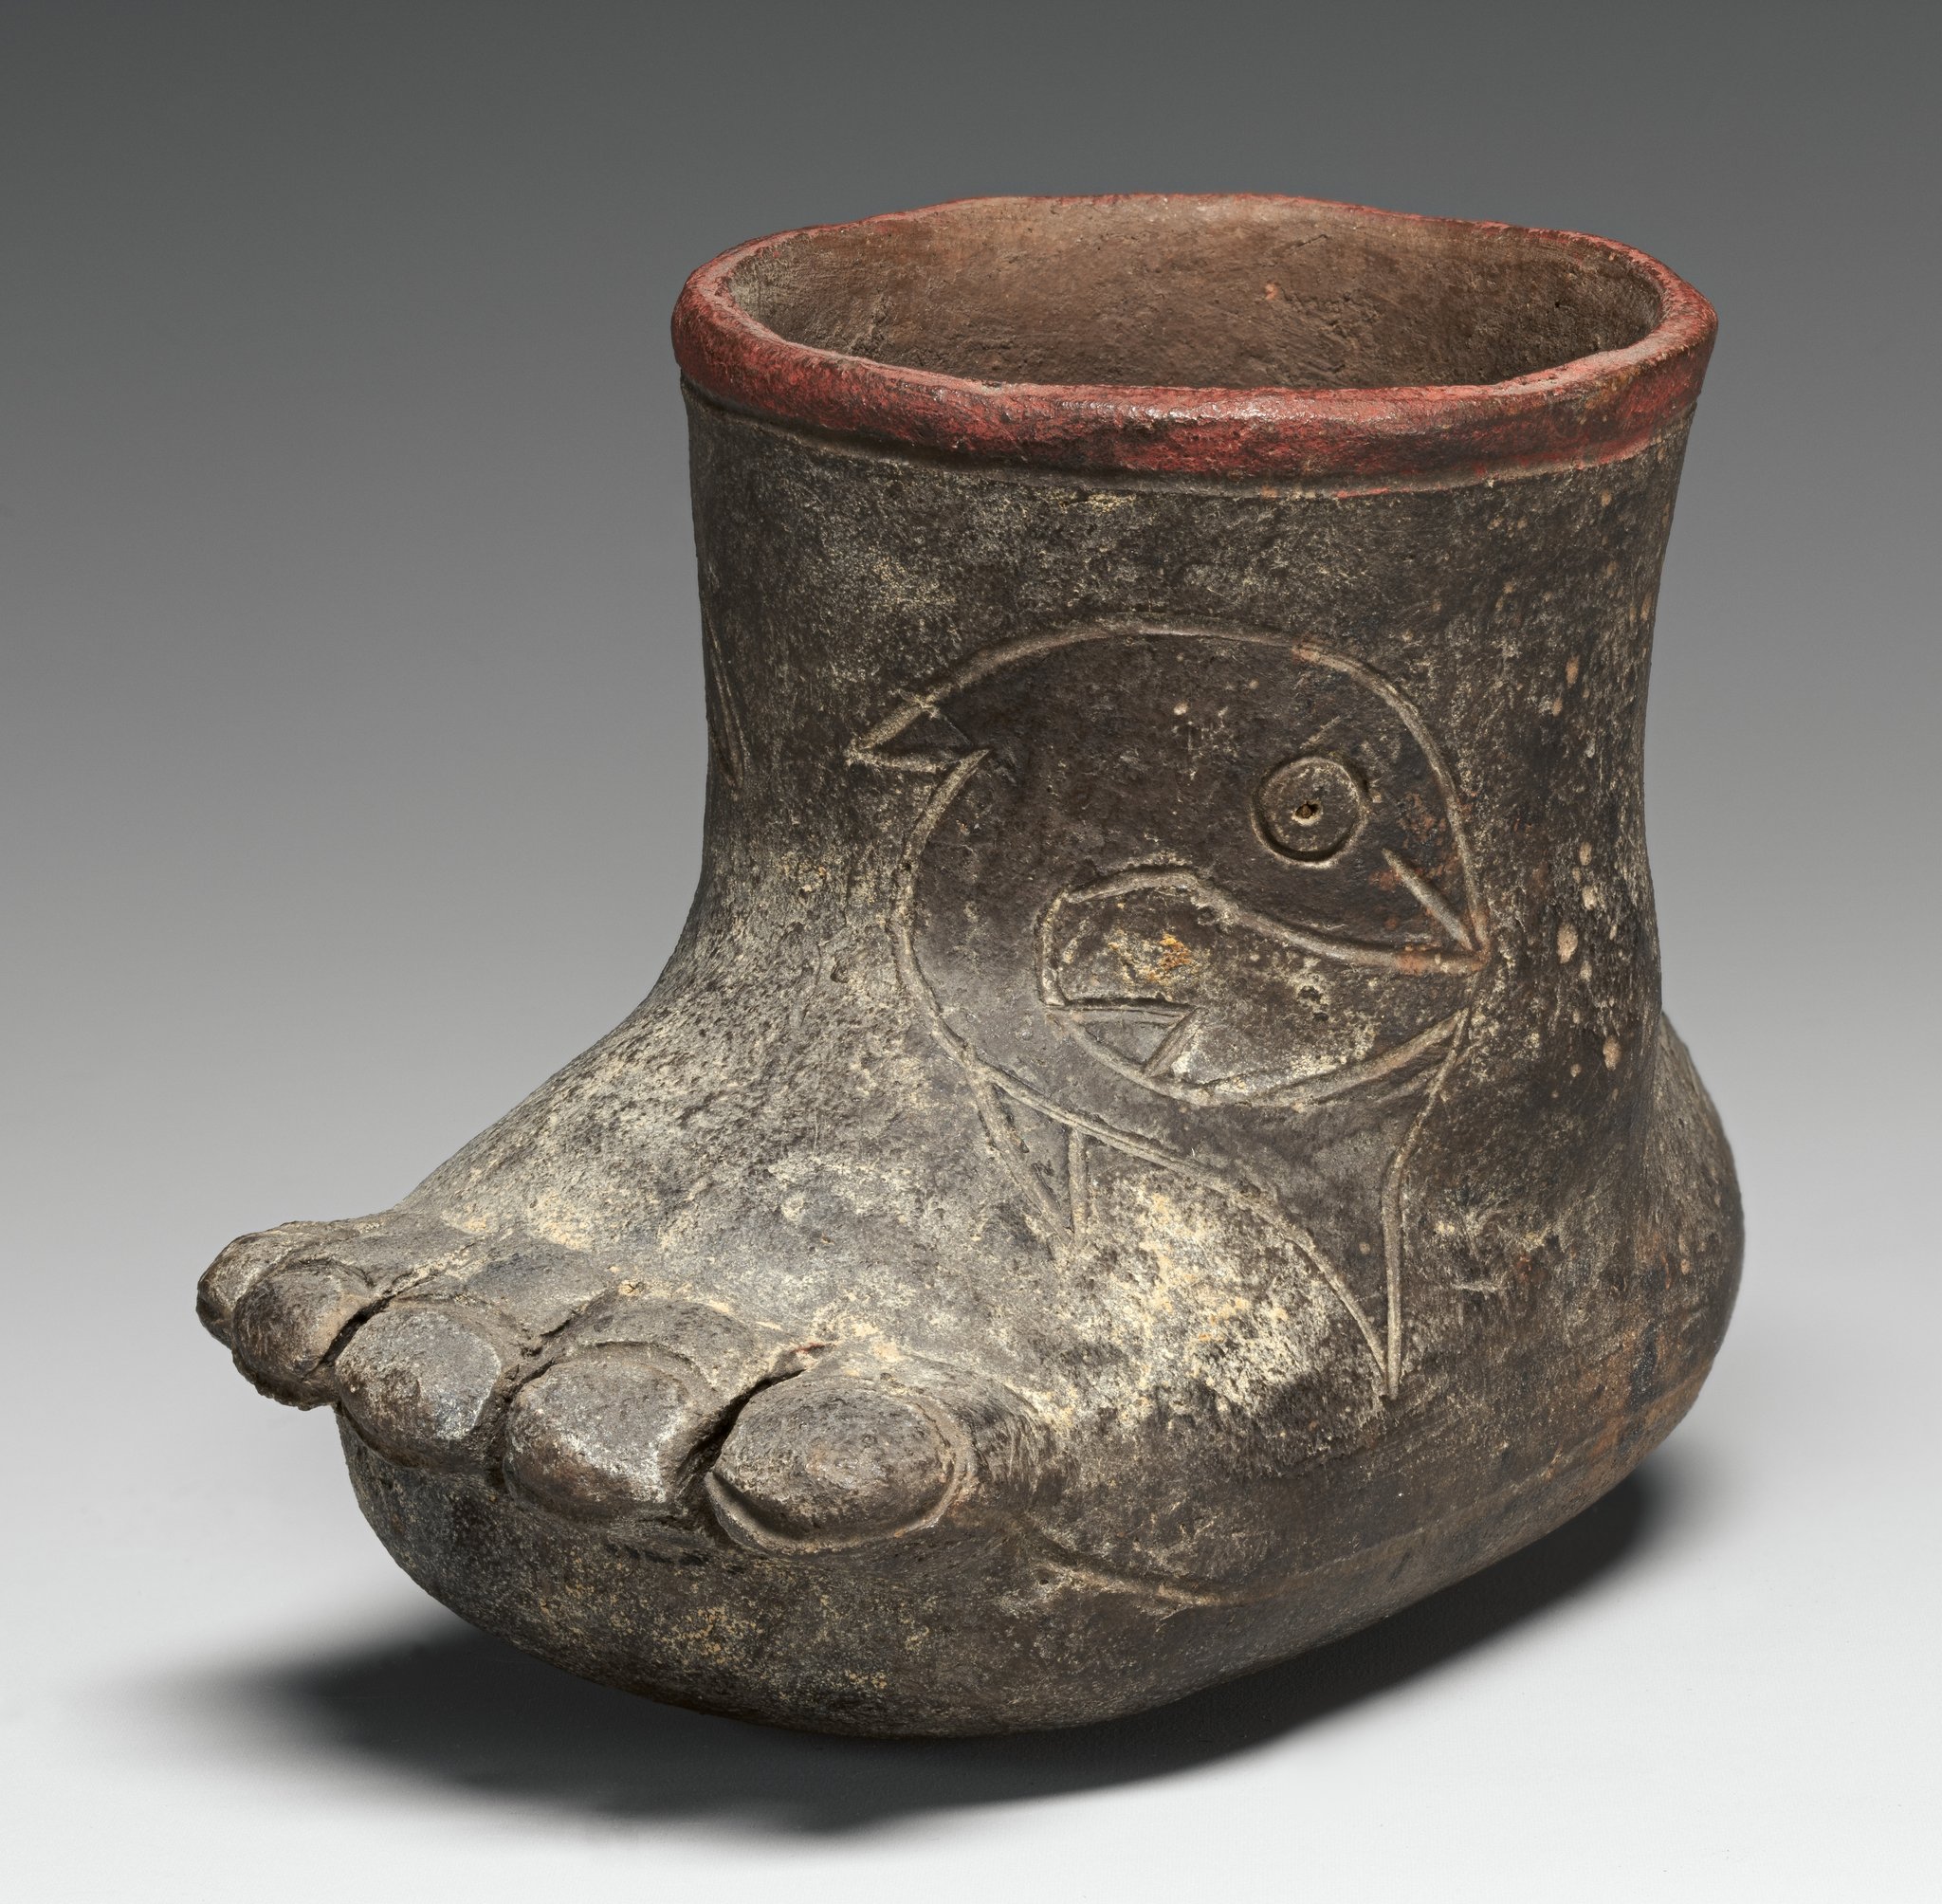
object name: jar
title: Foot Jar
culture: paracas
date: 200-1 BCE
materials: ceramic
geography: peru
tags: feet,fish